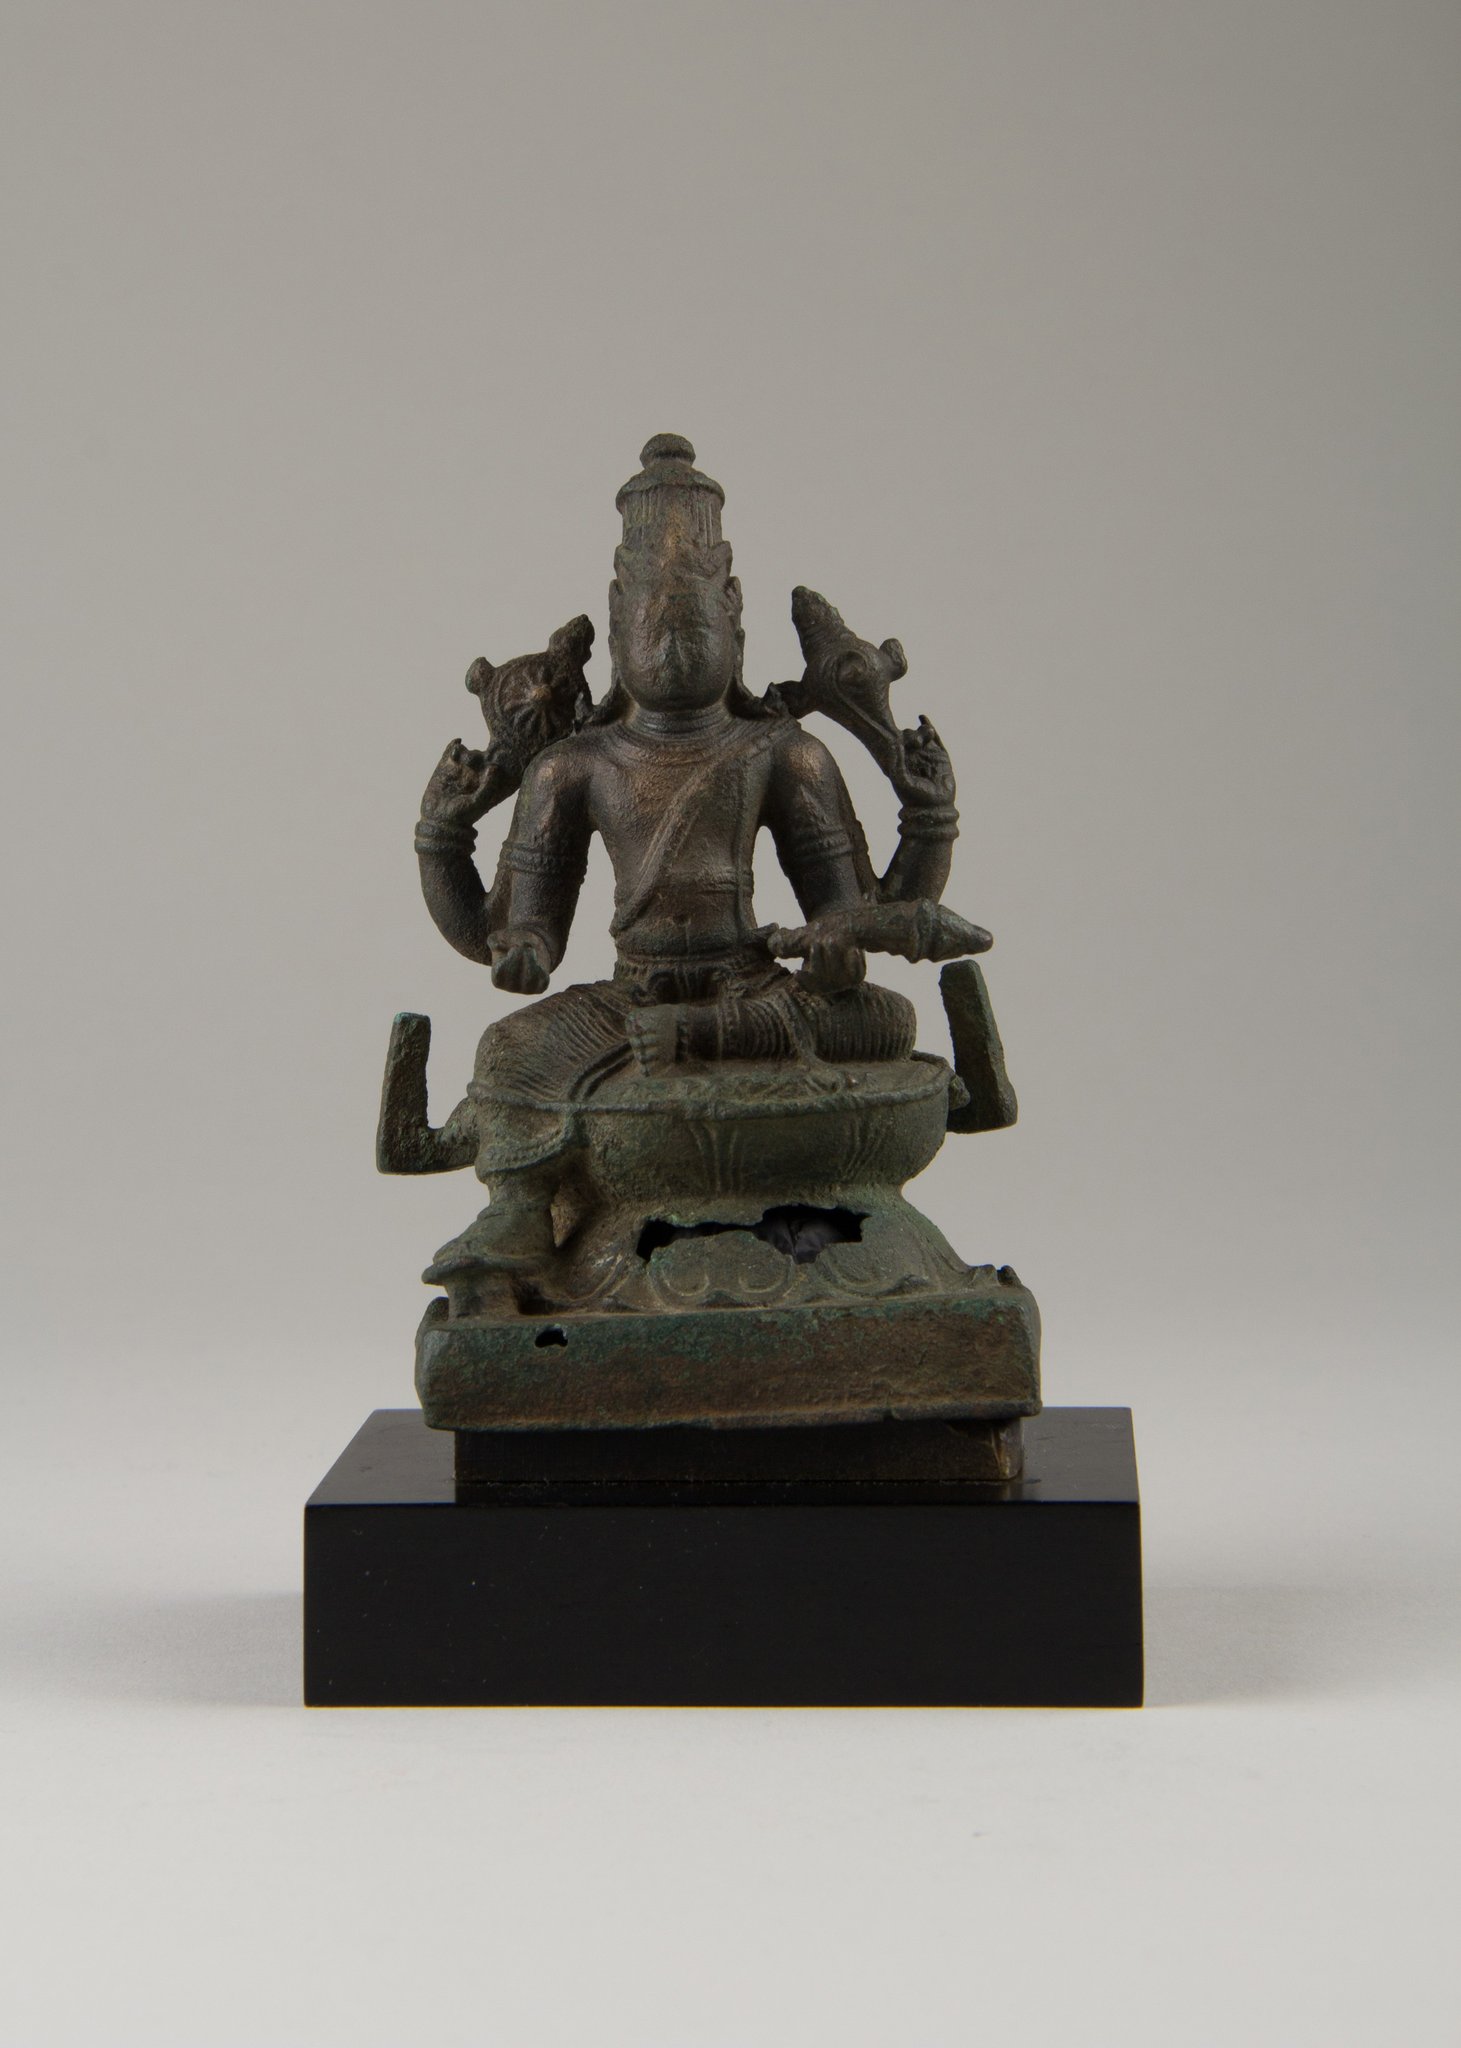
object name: figurine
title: Seated Vishnu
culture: indian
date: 701-900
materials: copper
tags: vishnu,hinduism